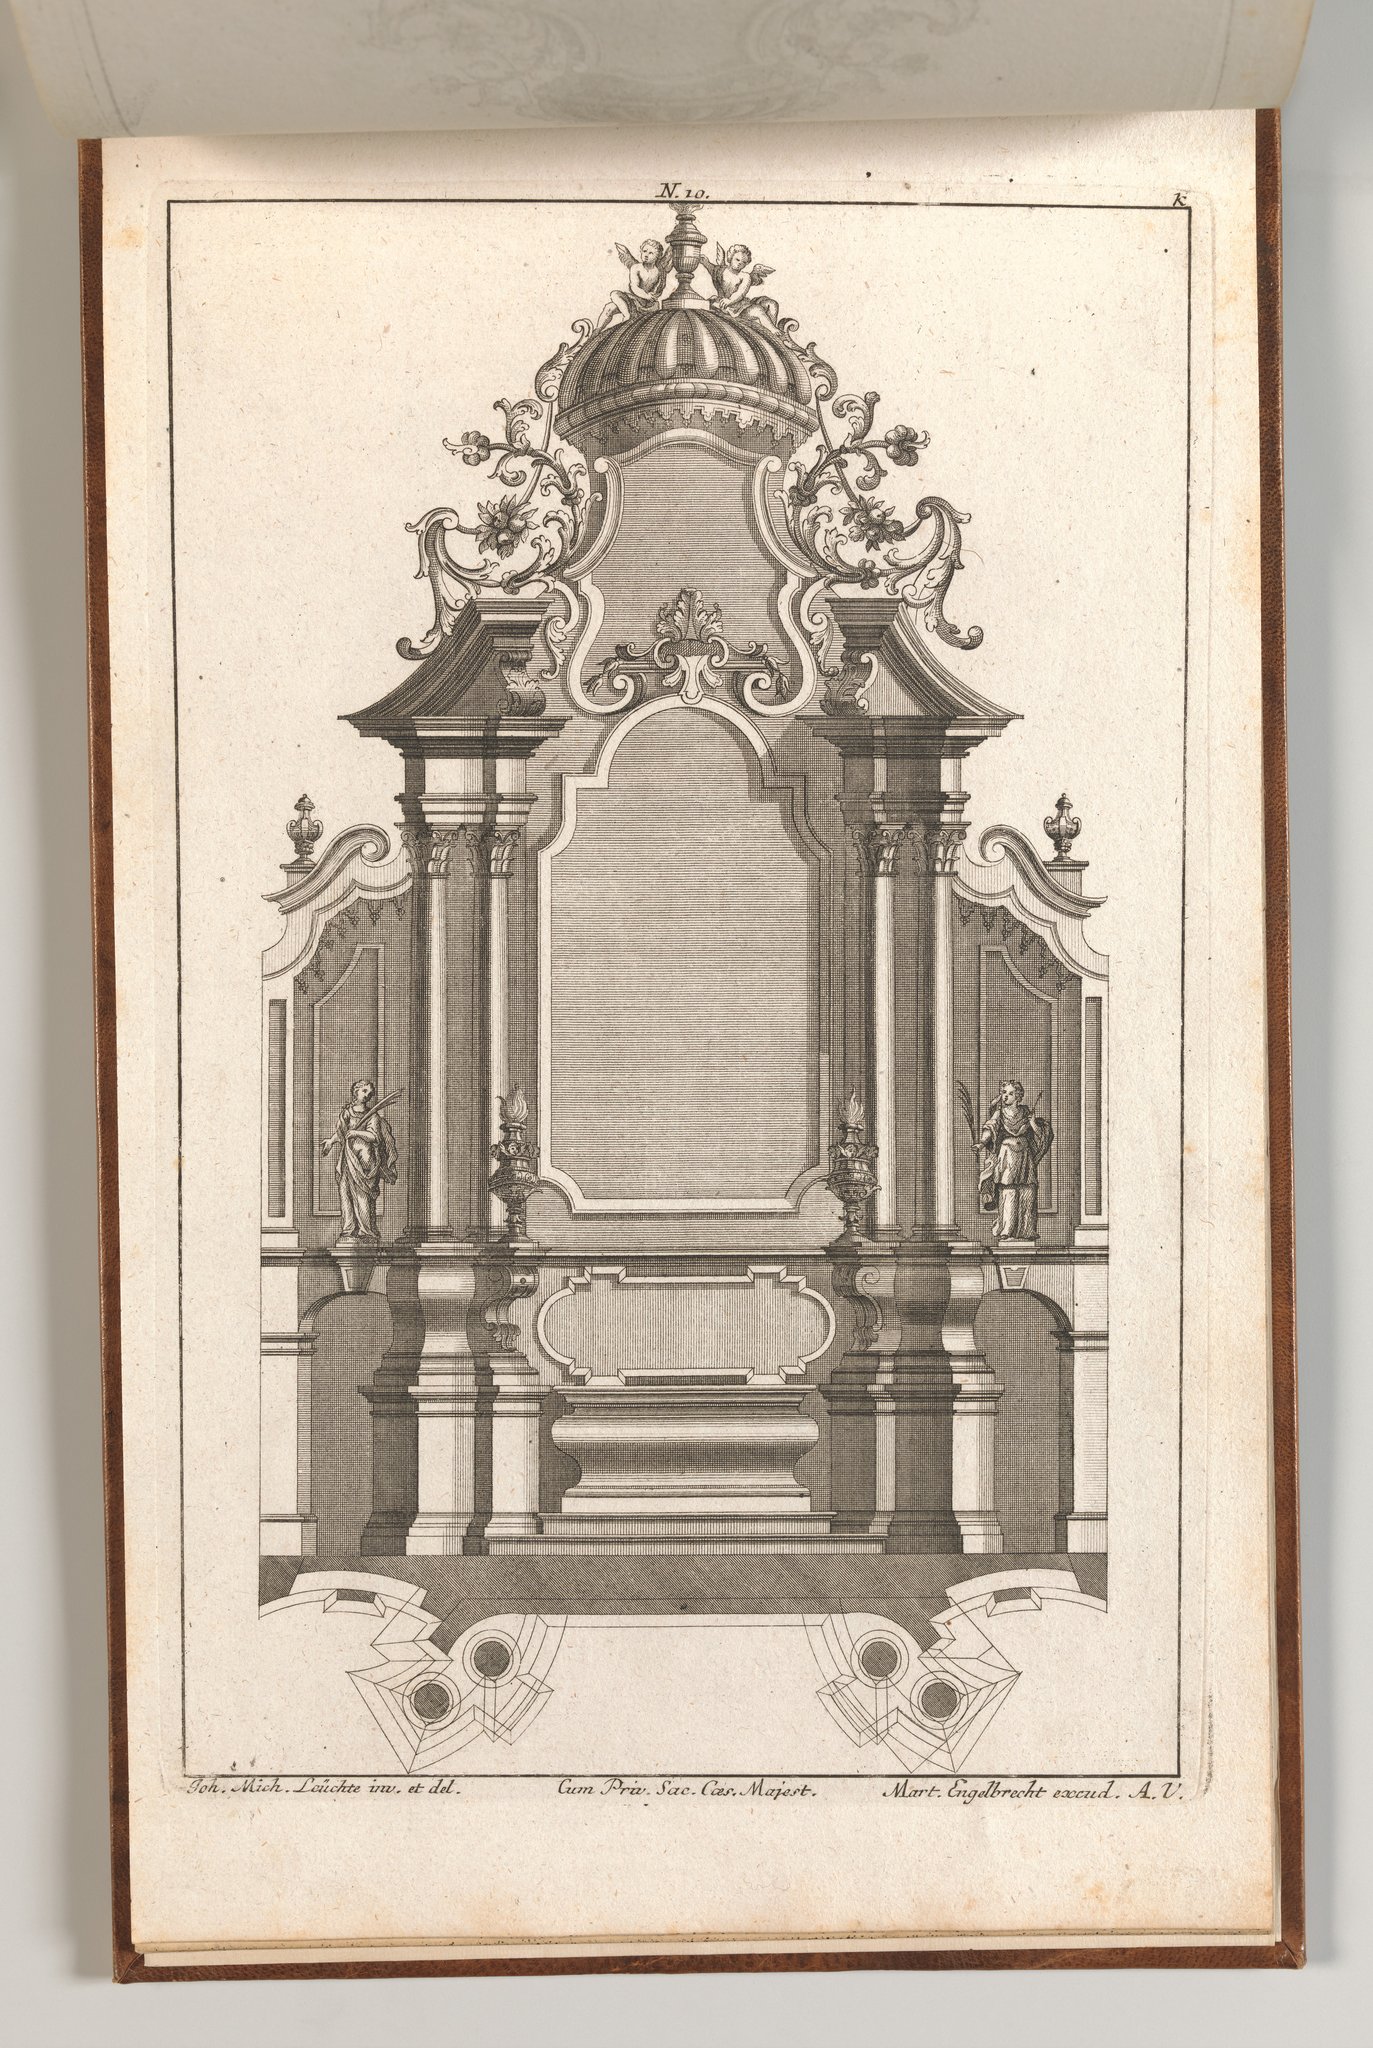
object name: album print ornament architecture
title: Design for a Monumental Altar, Plate k from 'Unterschiedliche Neu Inventierte Altäre mit darzu gehörigen Profillen u. Grundrißen.'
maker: martin engelbrecht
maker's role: publisher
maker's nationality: german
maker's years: 1684-1756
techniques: etching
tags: altars